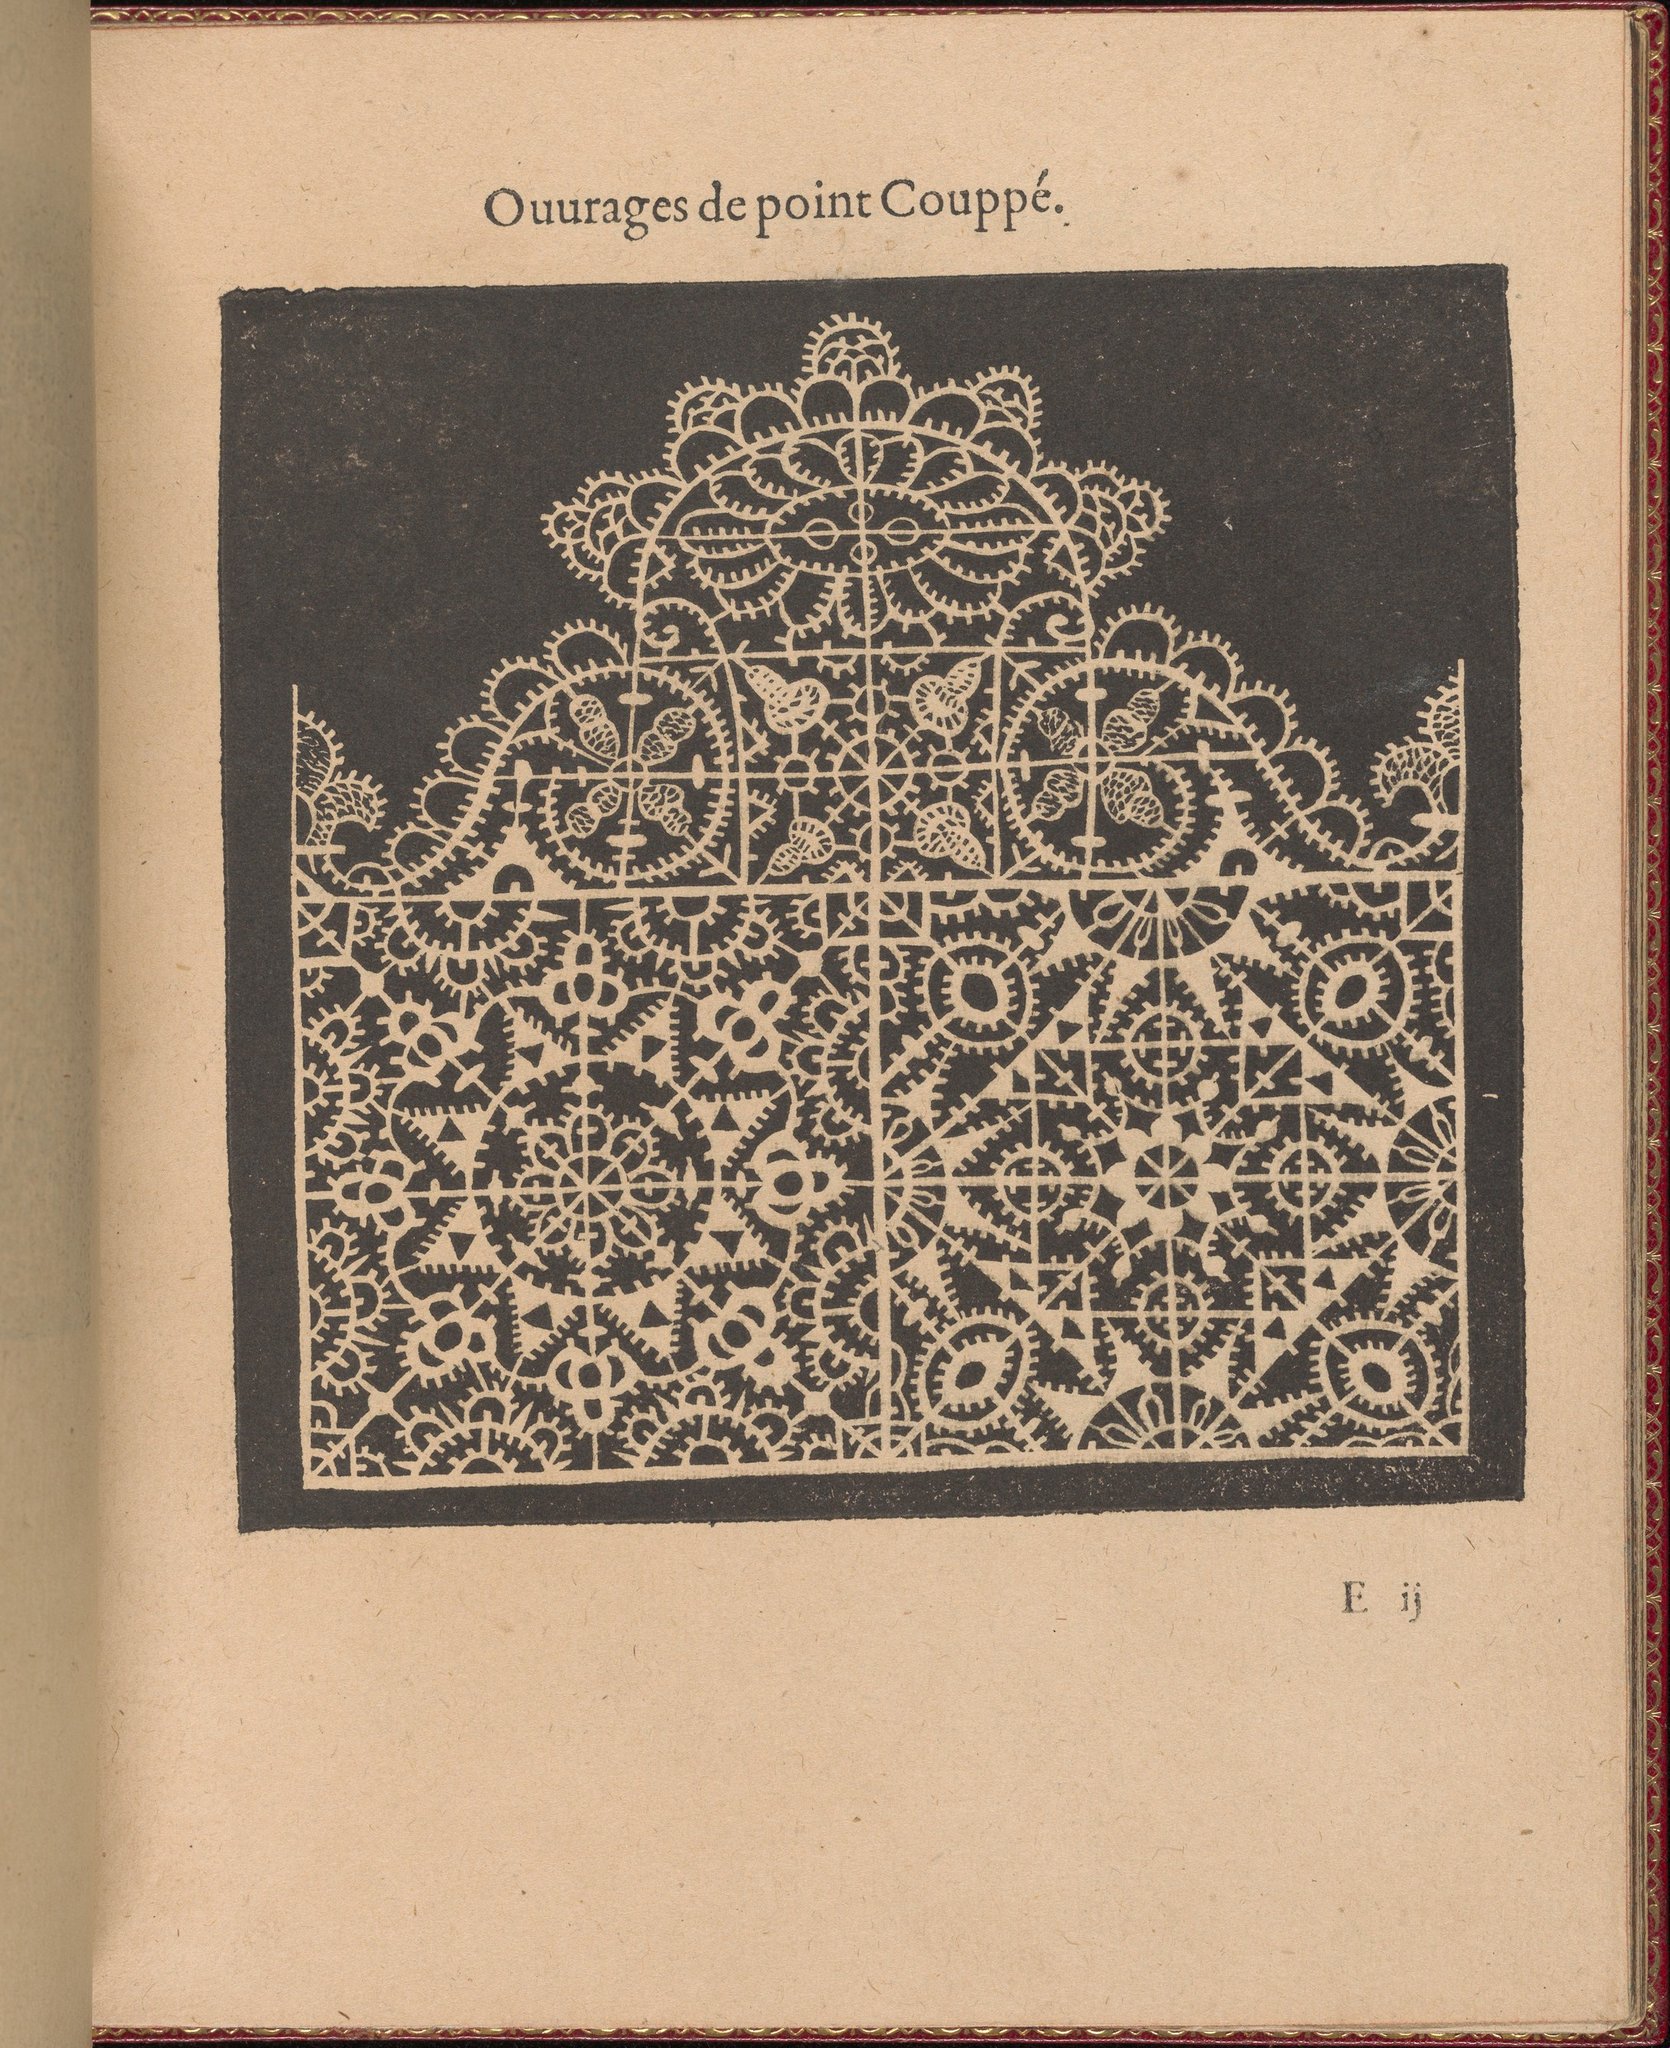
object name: book print ornament architecture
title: Les Singuliers et Nouveaux Portraicts... page 18 (recto)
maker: federico de vinciolo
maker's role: designer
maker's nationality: italian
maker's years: 1582-1599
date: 1588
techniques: woodcut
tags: ornament